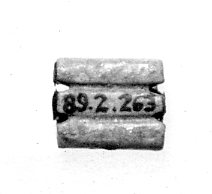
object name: bead, 3 tube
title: Bead of three parallel tubes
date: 1550-1295 BCE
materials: faience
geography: egypt